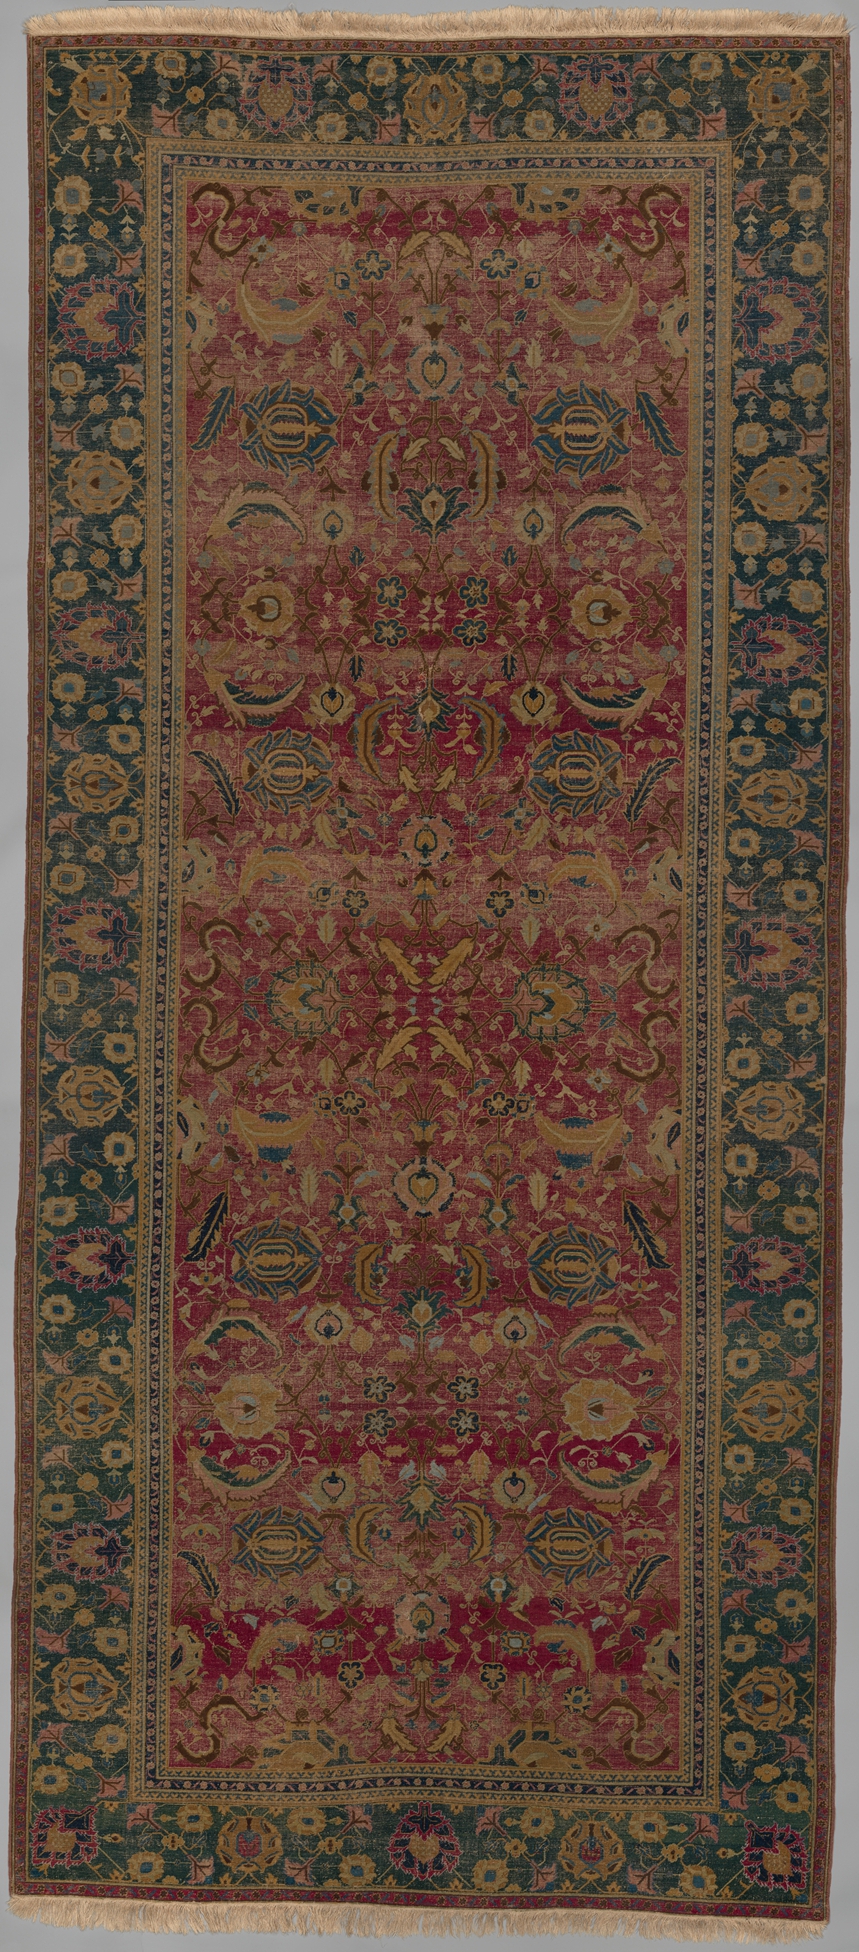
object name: carpet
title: Indo-Persian carpet with vine scroll and palmette pattern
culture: indo-persian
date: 1651-1700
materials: cotton, wool